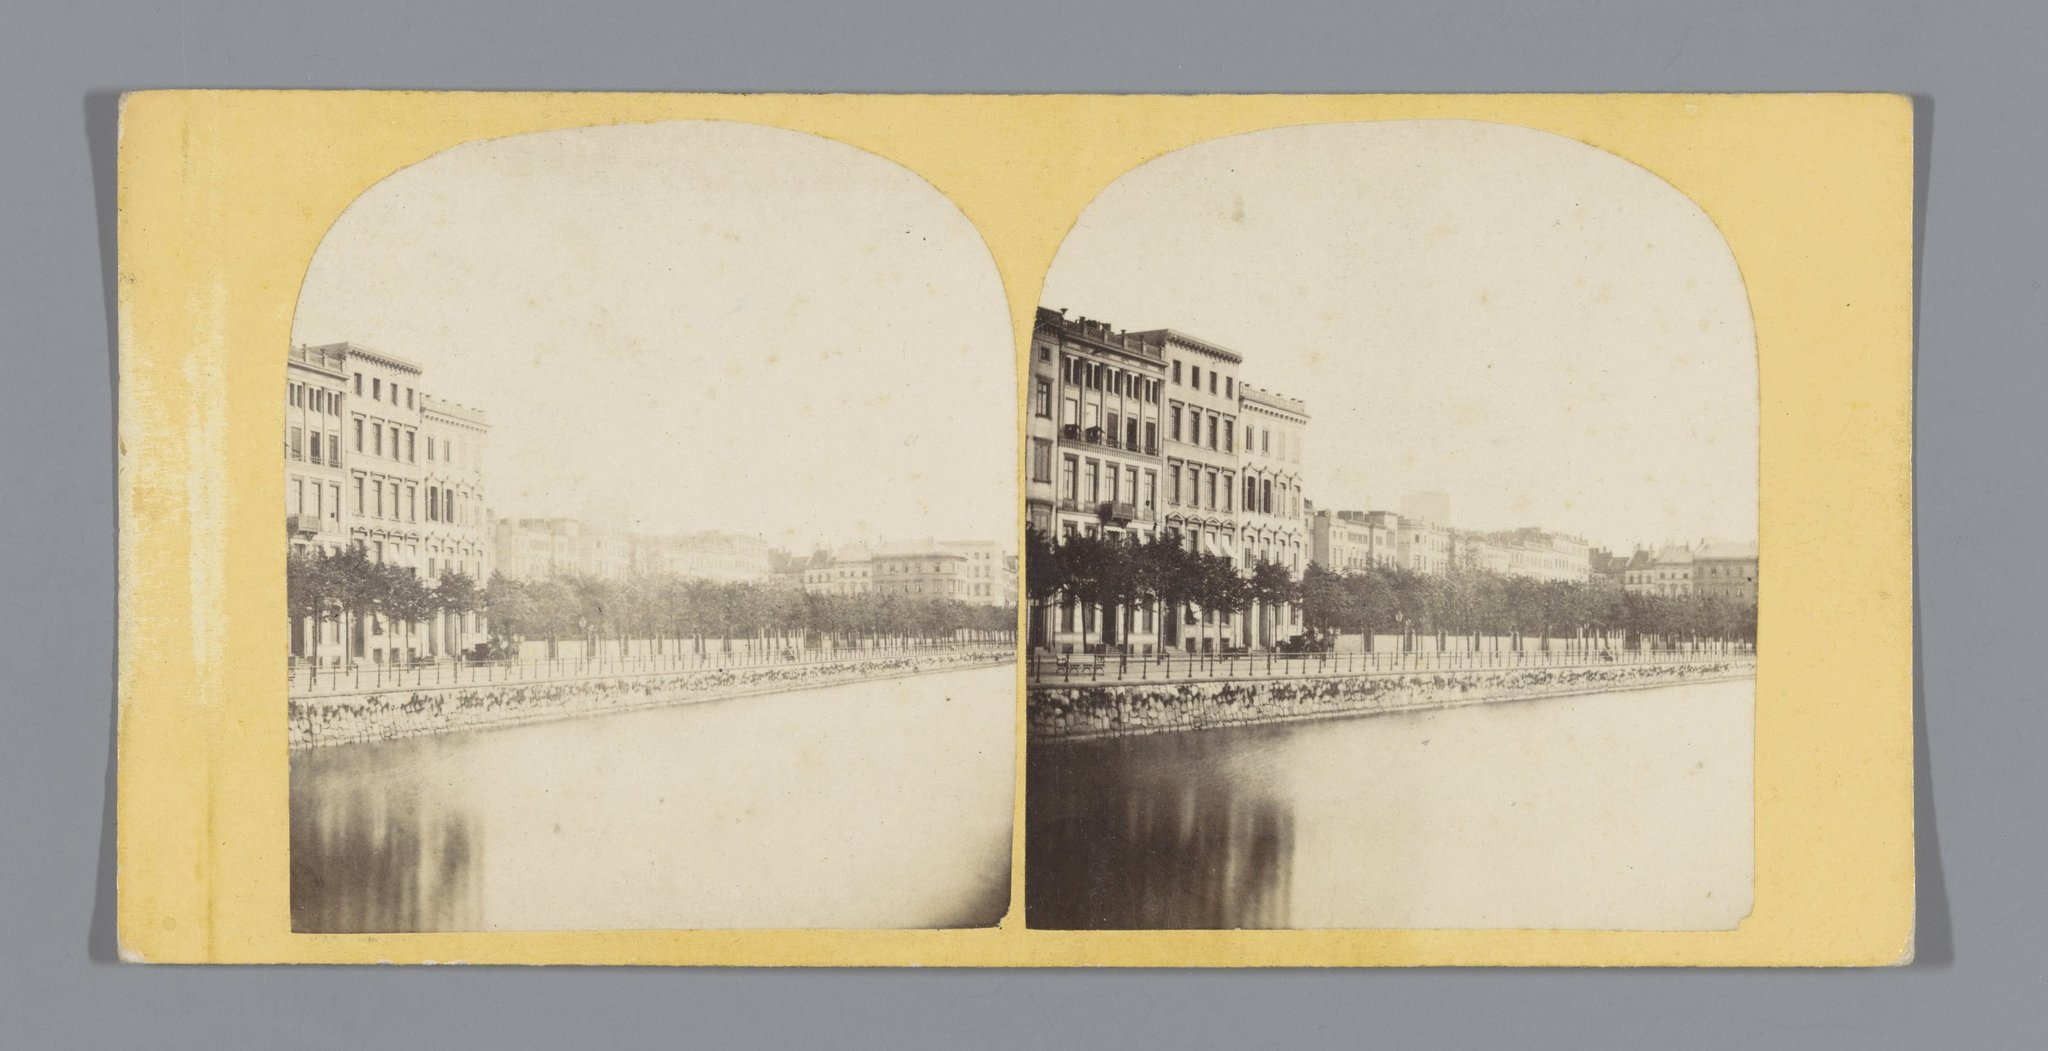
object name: stereograph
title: Gezicht op de Neuer Jungfernstieg te Hamburg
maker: Anonymous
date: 1855-1880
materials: cardboard, photographic support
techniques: albumen print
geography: hamburg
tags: quay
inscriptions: inscription: ‘Neue Jungfernstieg’